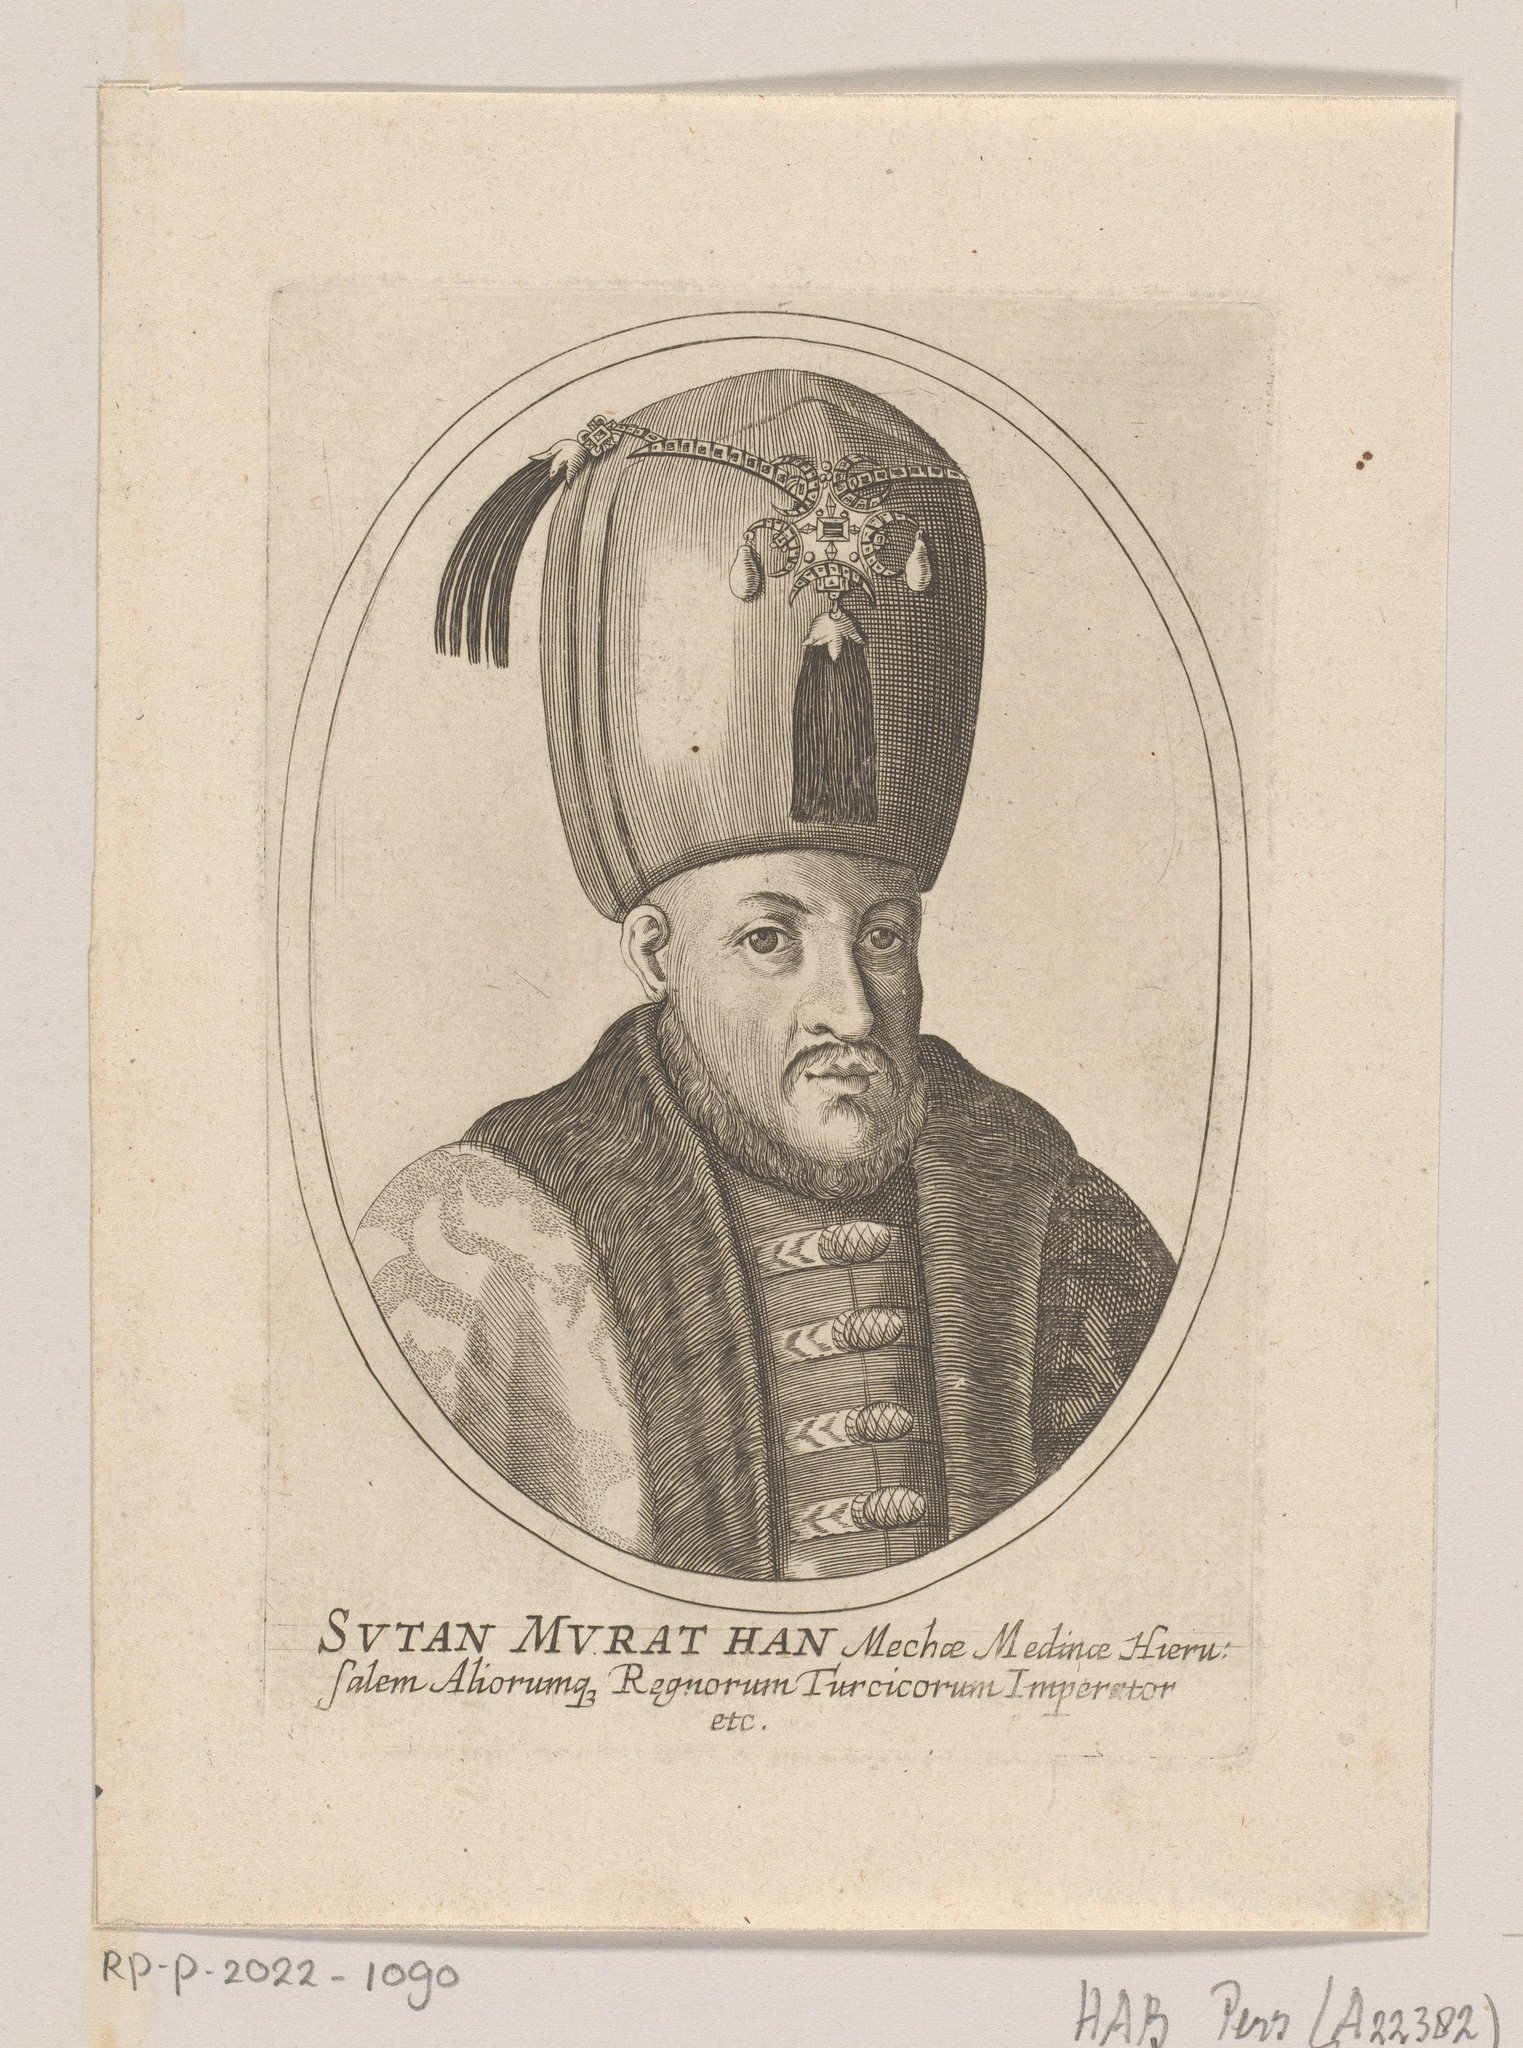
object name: print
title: Portret van Murat IV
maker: Anonymous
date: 1623-1699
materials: paper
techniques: engraving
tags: historical persons, other sovereign (with title)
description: Met drieregelig onderschrift in het Latijn.